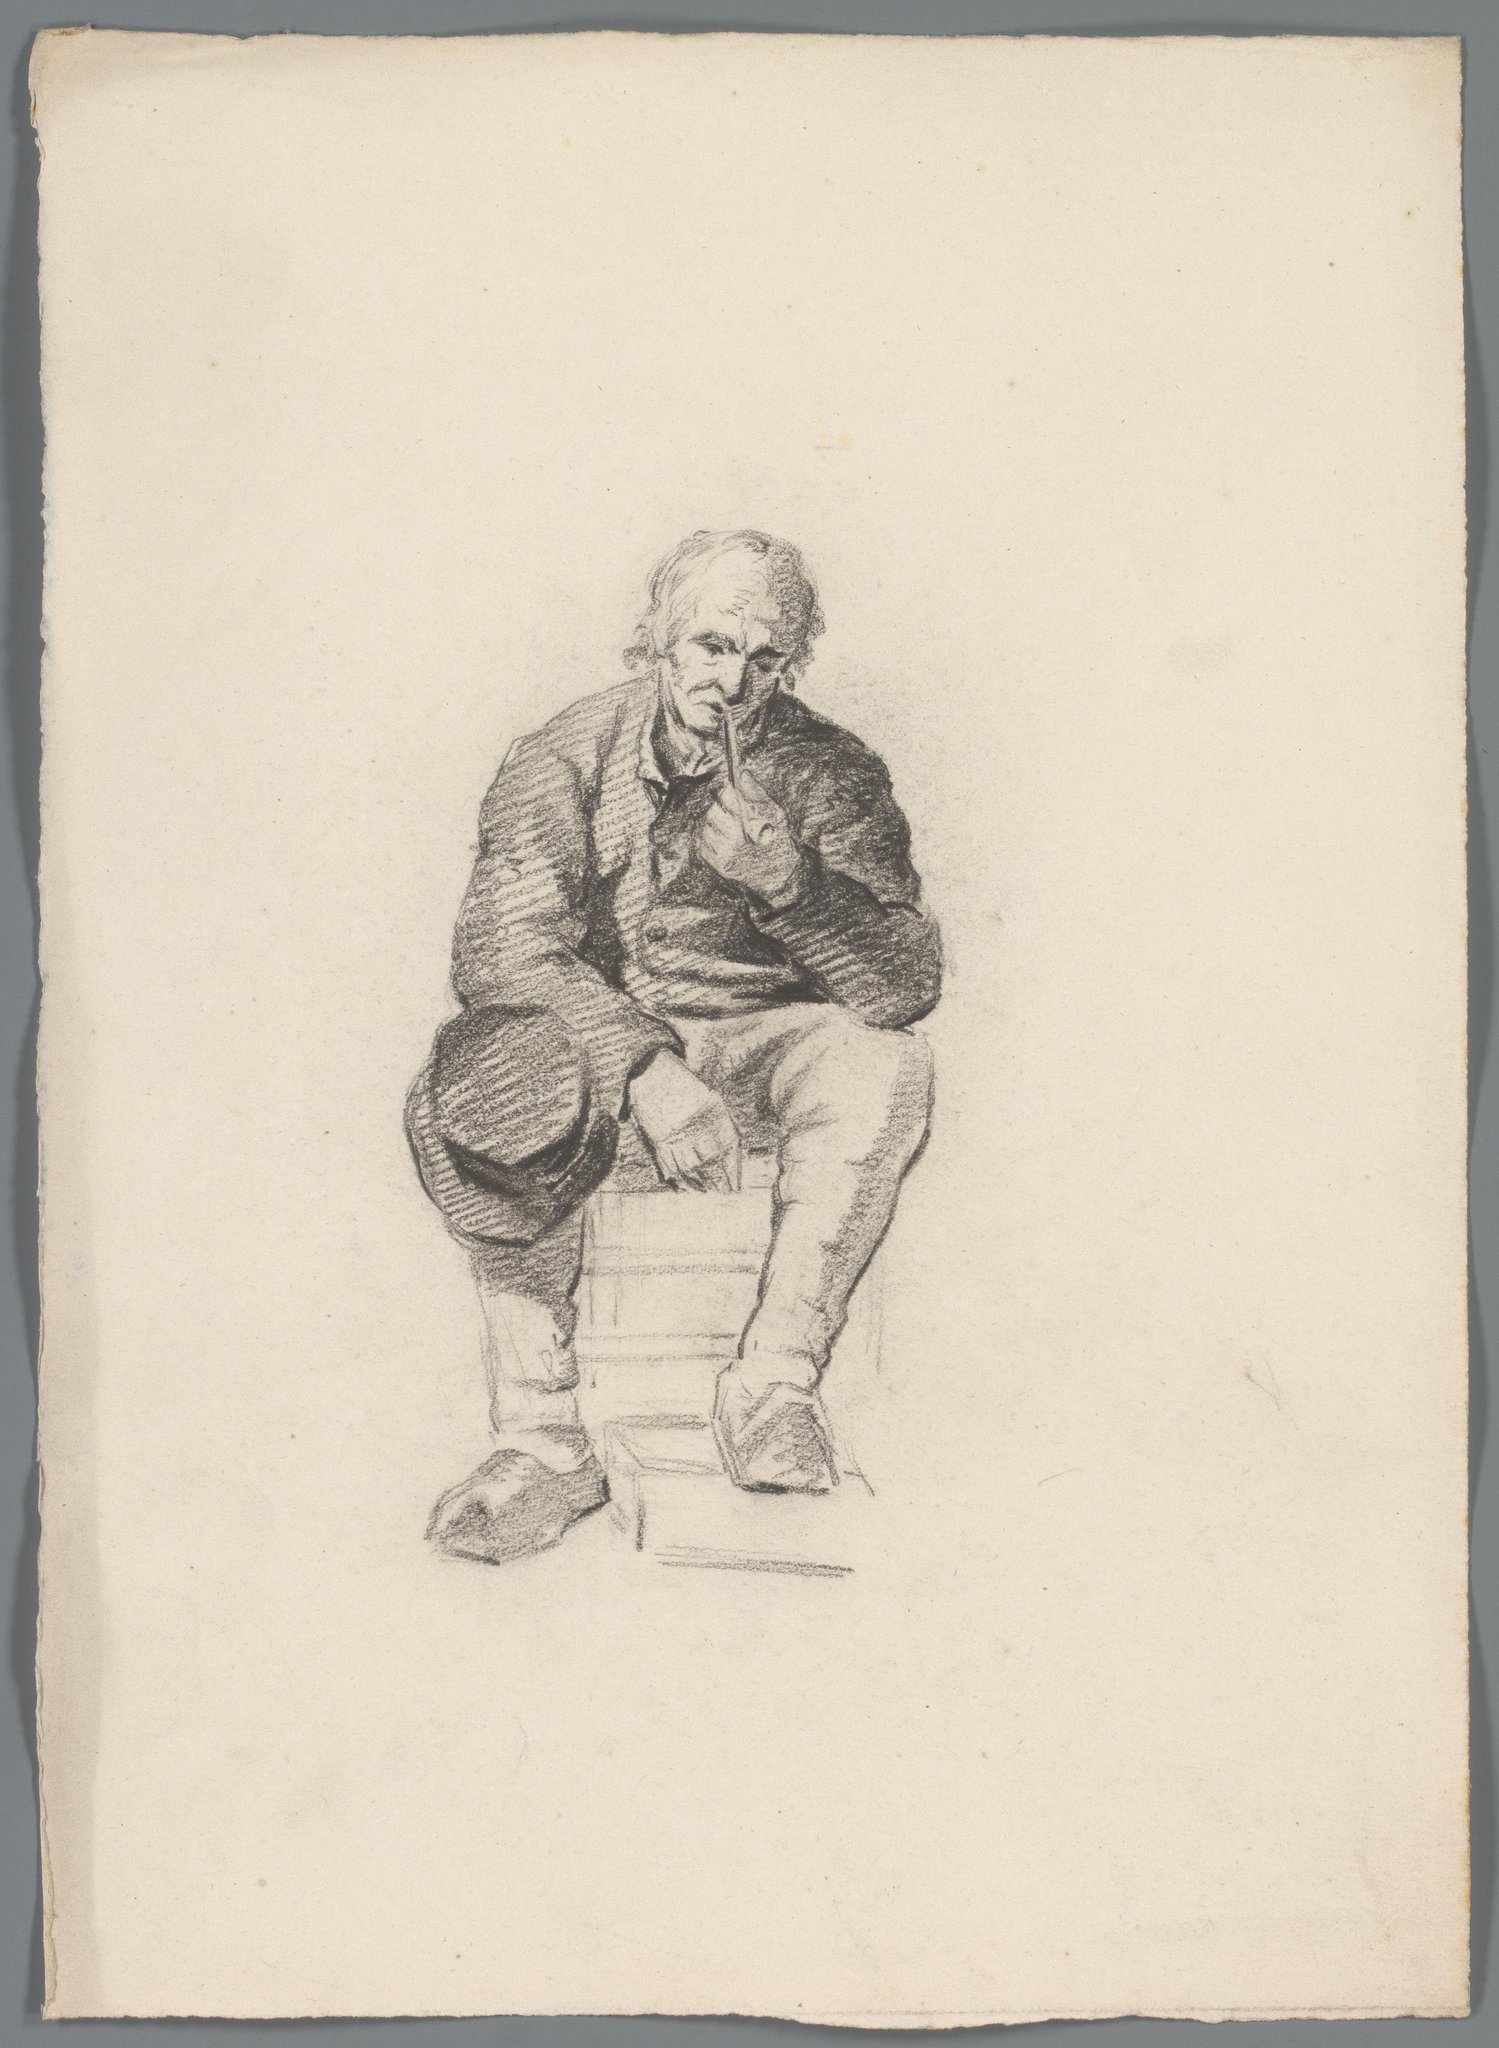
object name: drawing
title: Zittende man met pijp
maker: Anonymous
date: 1820-1830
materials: chalk, paper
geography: the hague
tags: sitting figure, adult man, pipe ~ tobacco, head-gear: hat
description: Tekeningen waarschijnlijk ontstaan bij het Haagse kunstgenootschap ‘Tot Nut der Tekenkunst’, waar twee keer per week tekenavonden werden georganiseerd met geklede modellen.